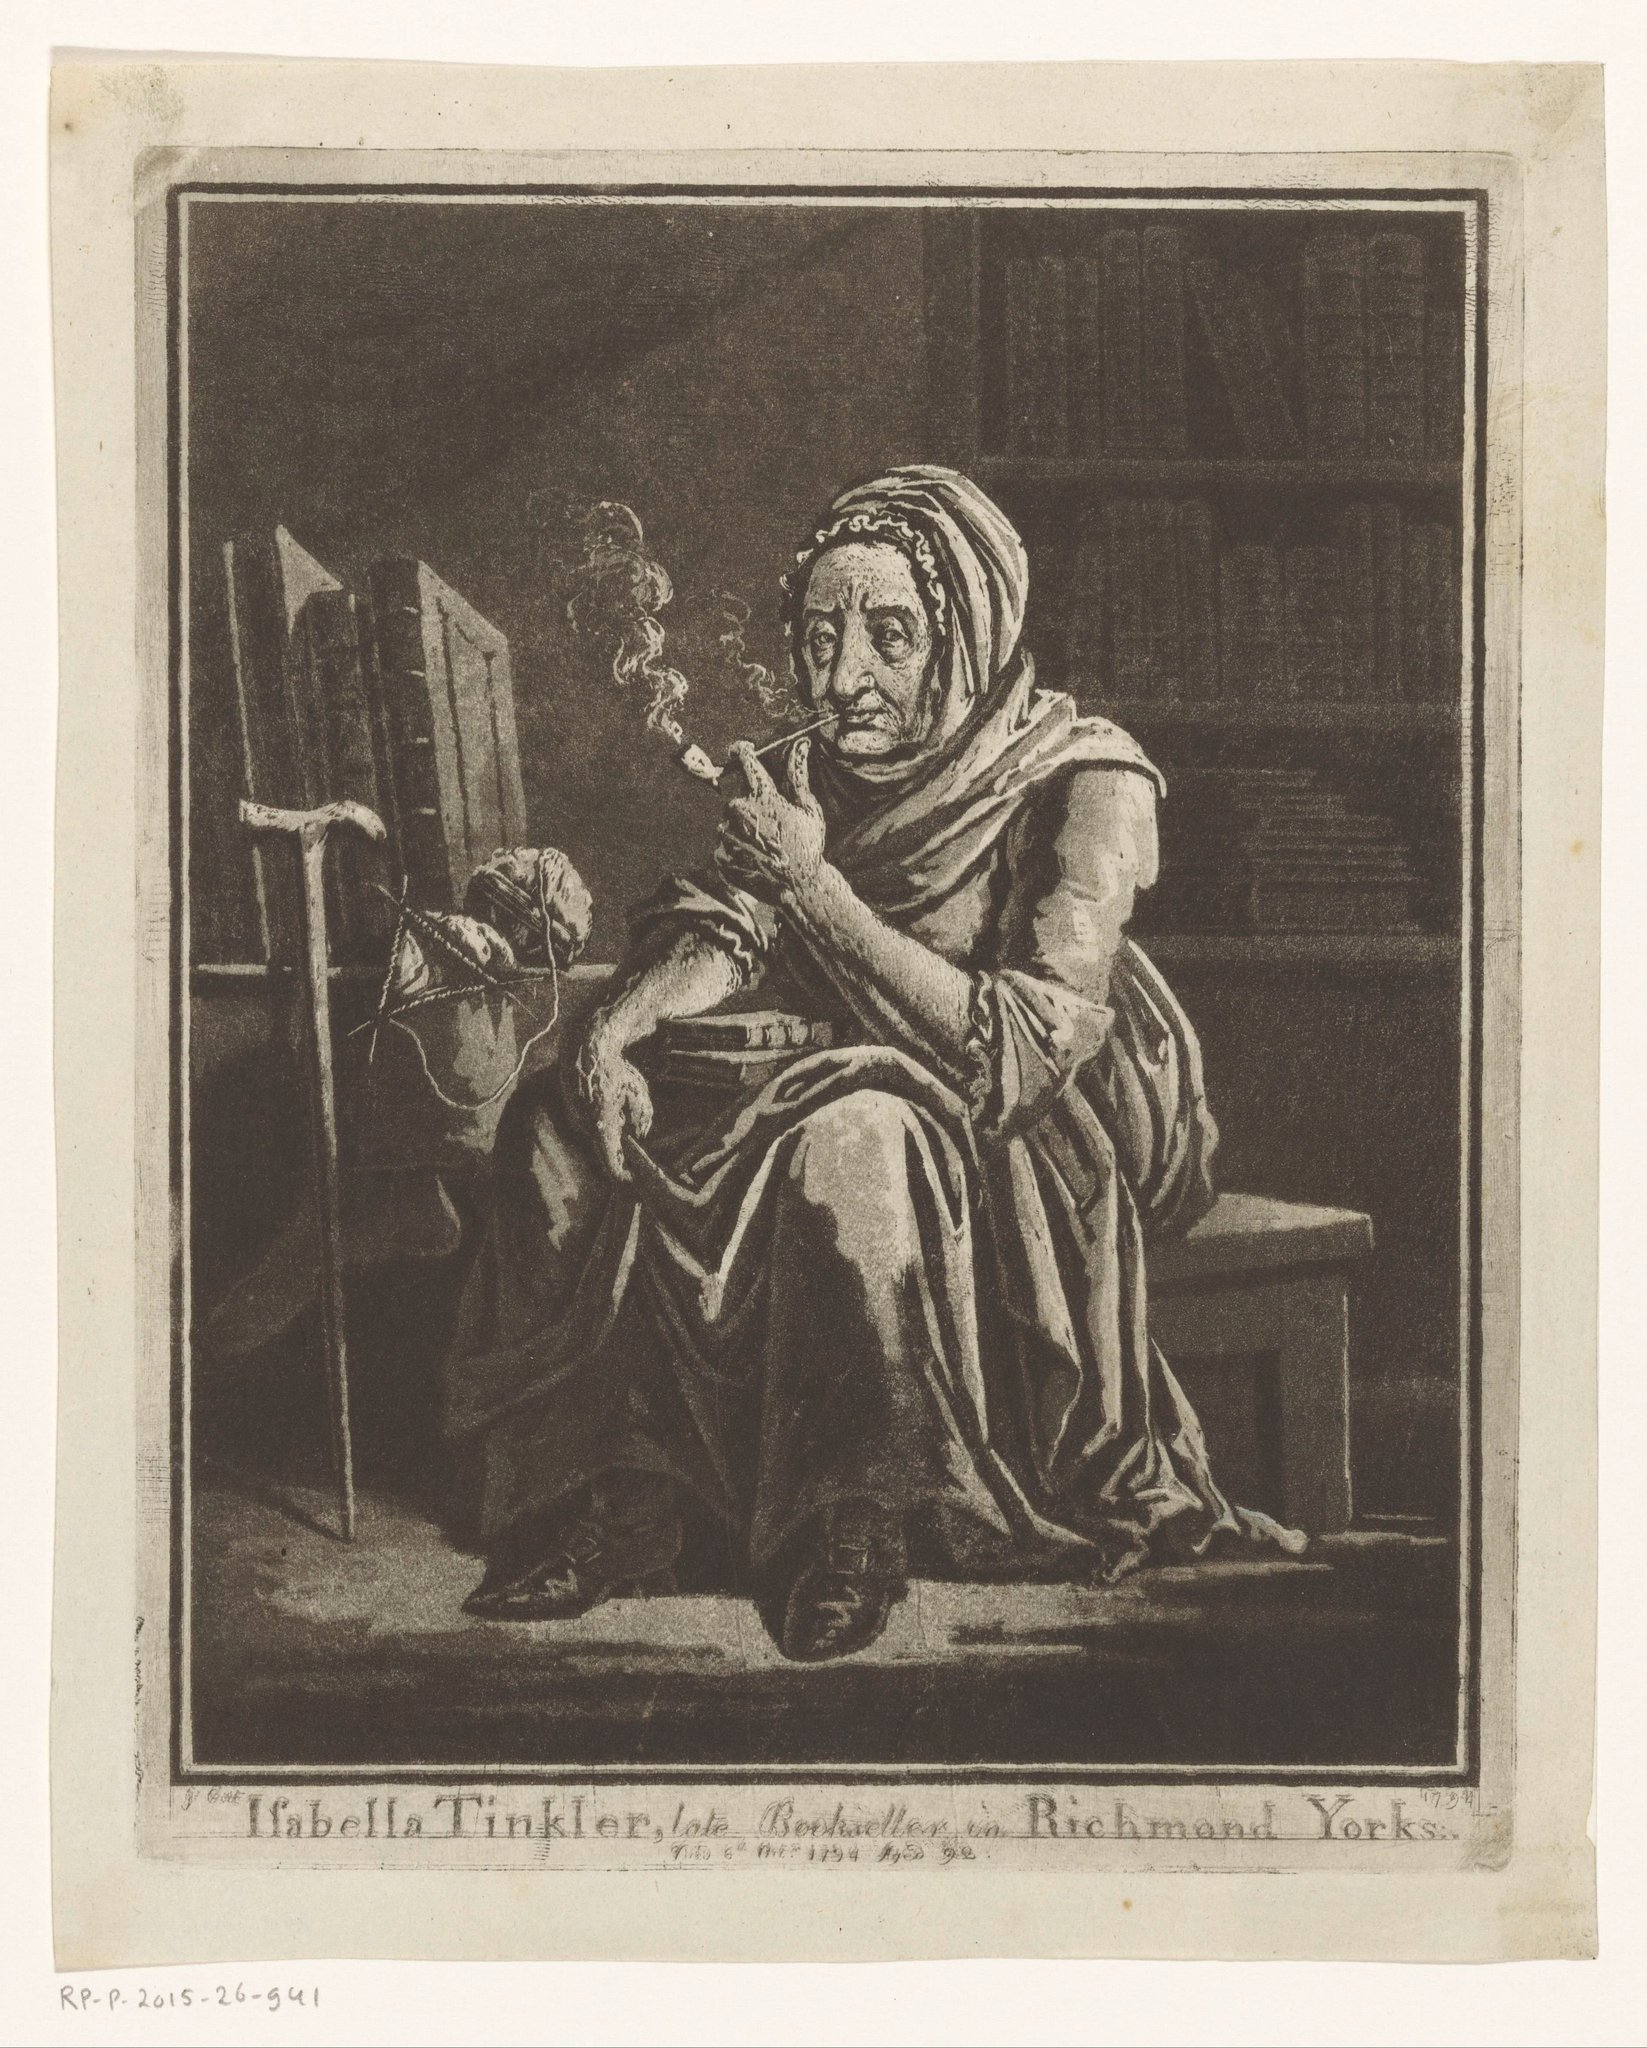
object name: print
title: Portret van de boekverkoopster Isabella Tinkler uit Richmond op 92-jarige leeftijd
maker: george cuitt (i)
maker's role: draughtsman, painter, print maker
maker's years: 1743-1818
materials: paper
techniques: aquatint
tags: pipe ~ tobacco, knitting, book-shop, bookseller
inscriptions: collector's mark: Lugt 4779, collector's mark: Lugt 2228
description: Een pijprokende vrouw, zittend op een krukje voor een boekenkast. In haar schoot liggen twee boeken, naast haar een stok en een breiwerk met een bol wol.